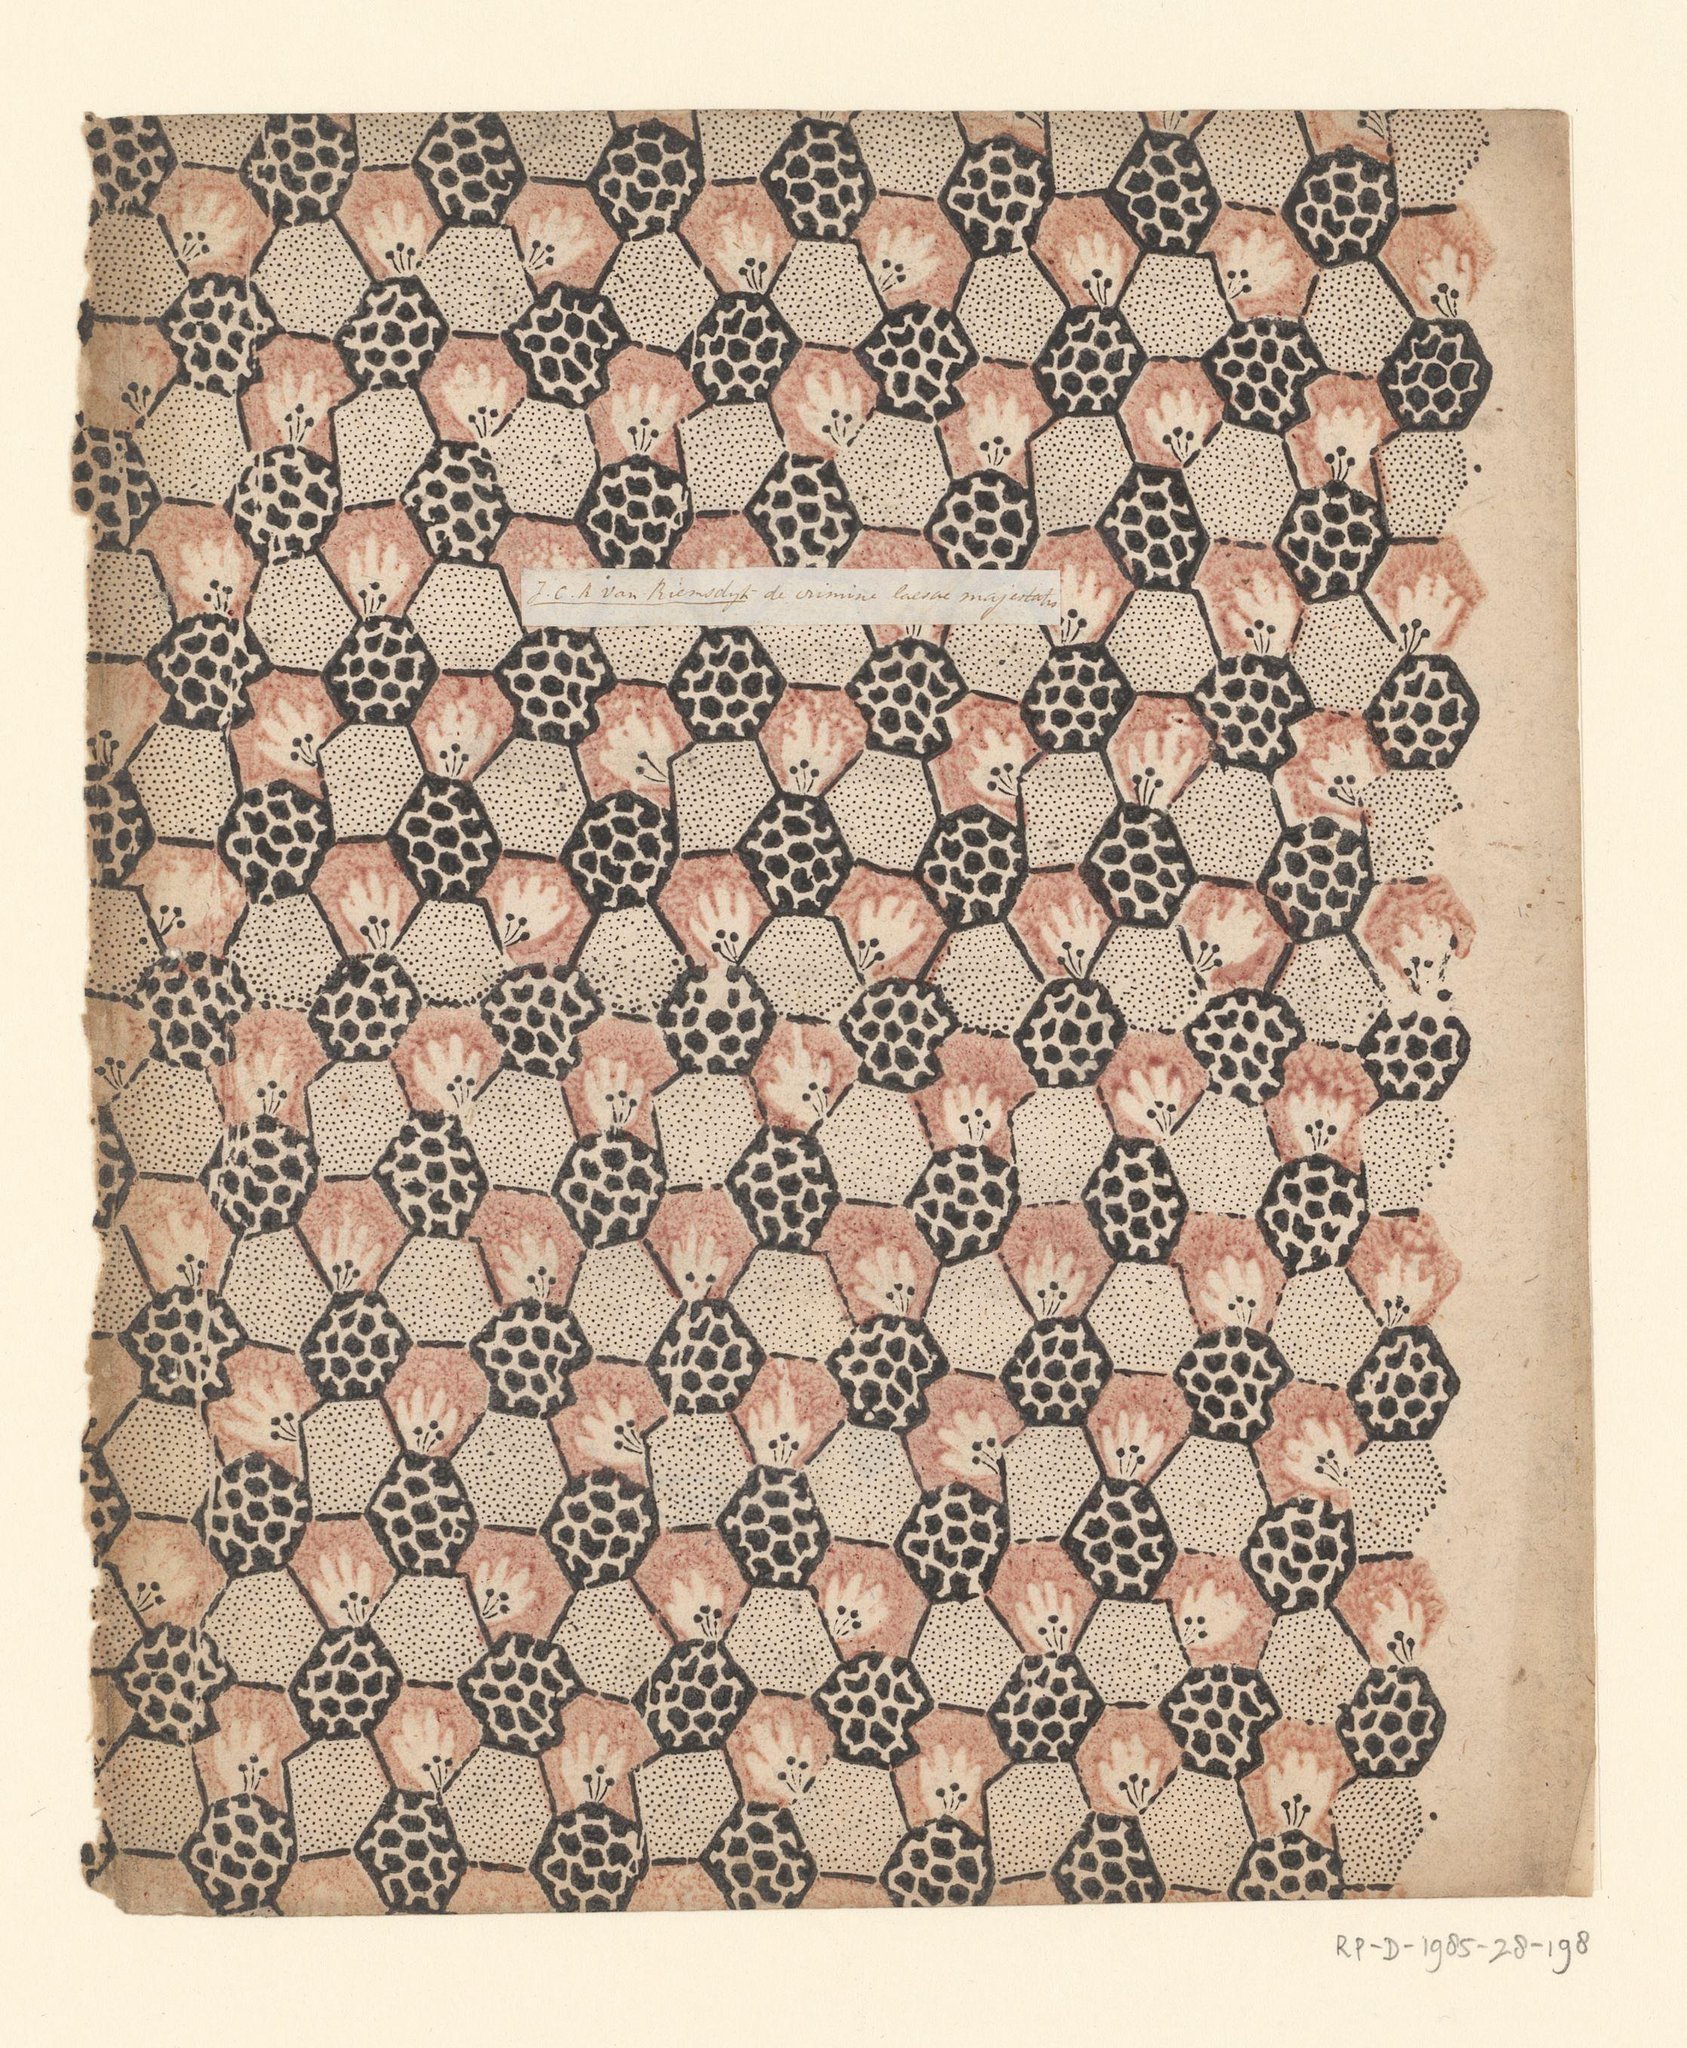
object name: printed paper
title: Blad met patroon van vijfhoeken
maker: Anonymous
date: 1750-1900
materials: paper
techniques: printing block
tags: ornament ~ geometric motifs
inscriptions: collector's mark: Lugt 2228, collector's mark: Lugt 2760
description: Blad met patroon van vijfhoeken. Met etiket met opschrift: 'J.C.A. van Riemsdijk ... majestatis.' Helft van een omslag.